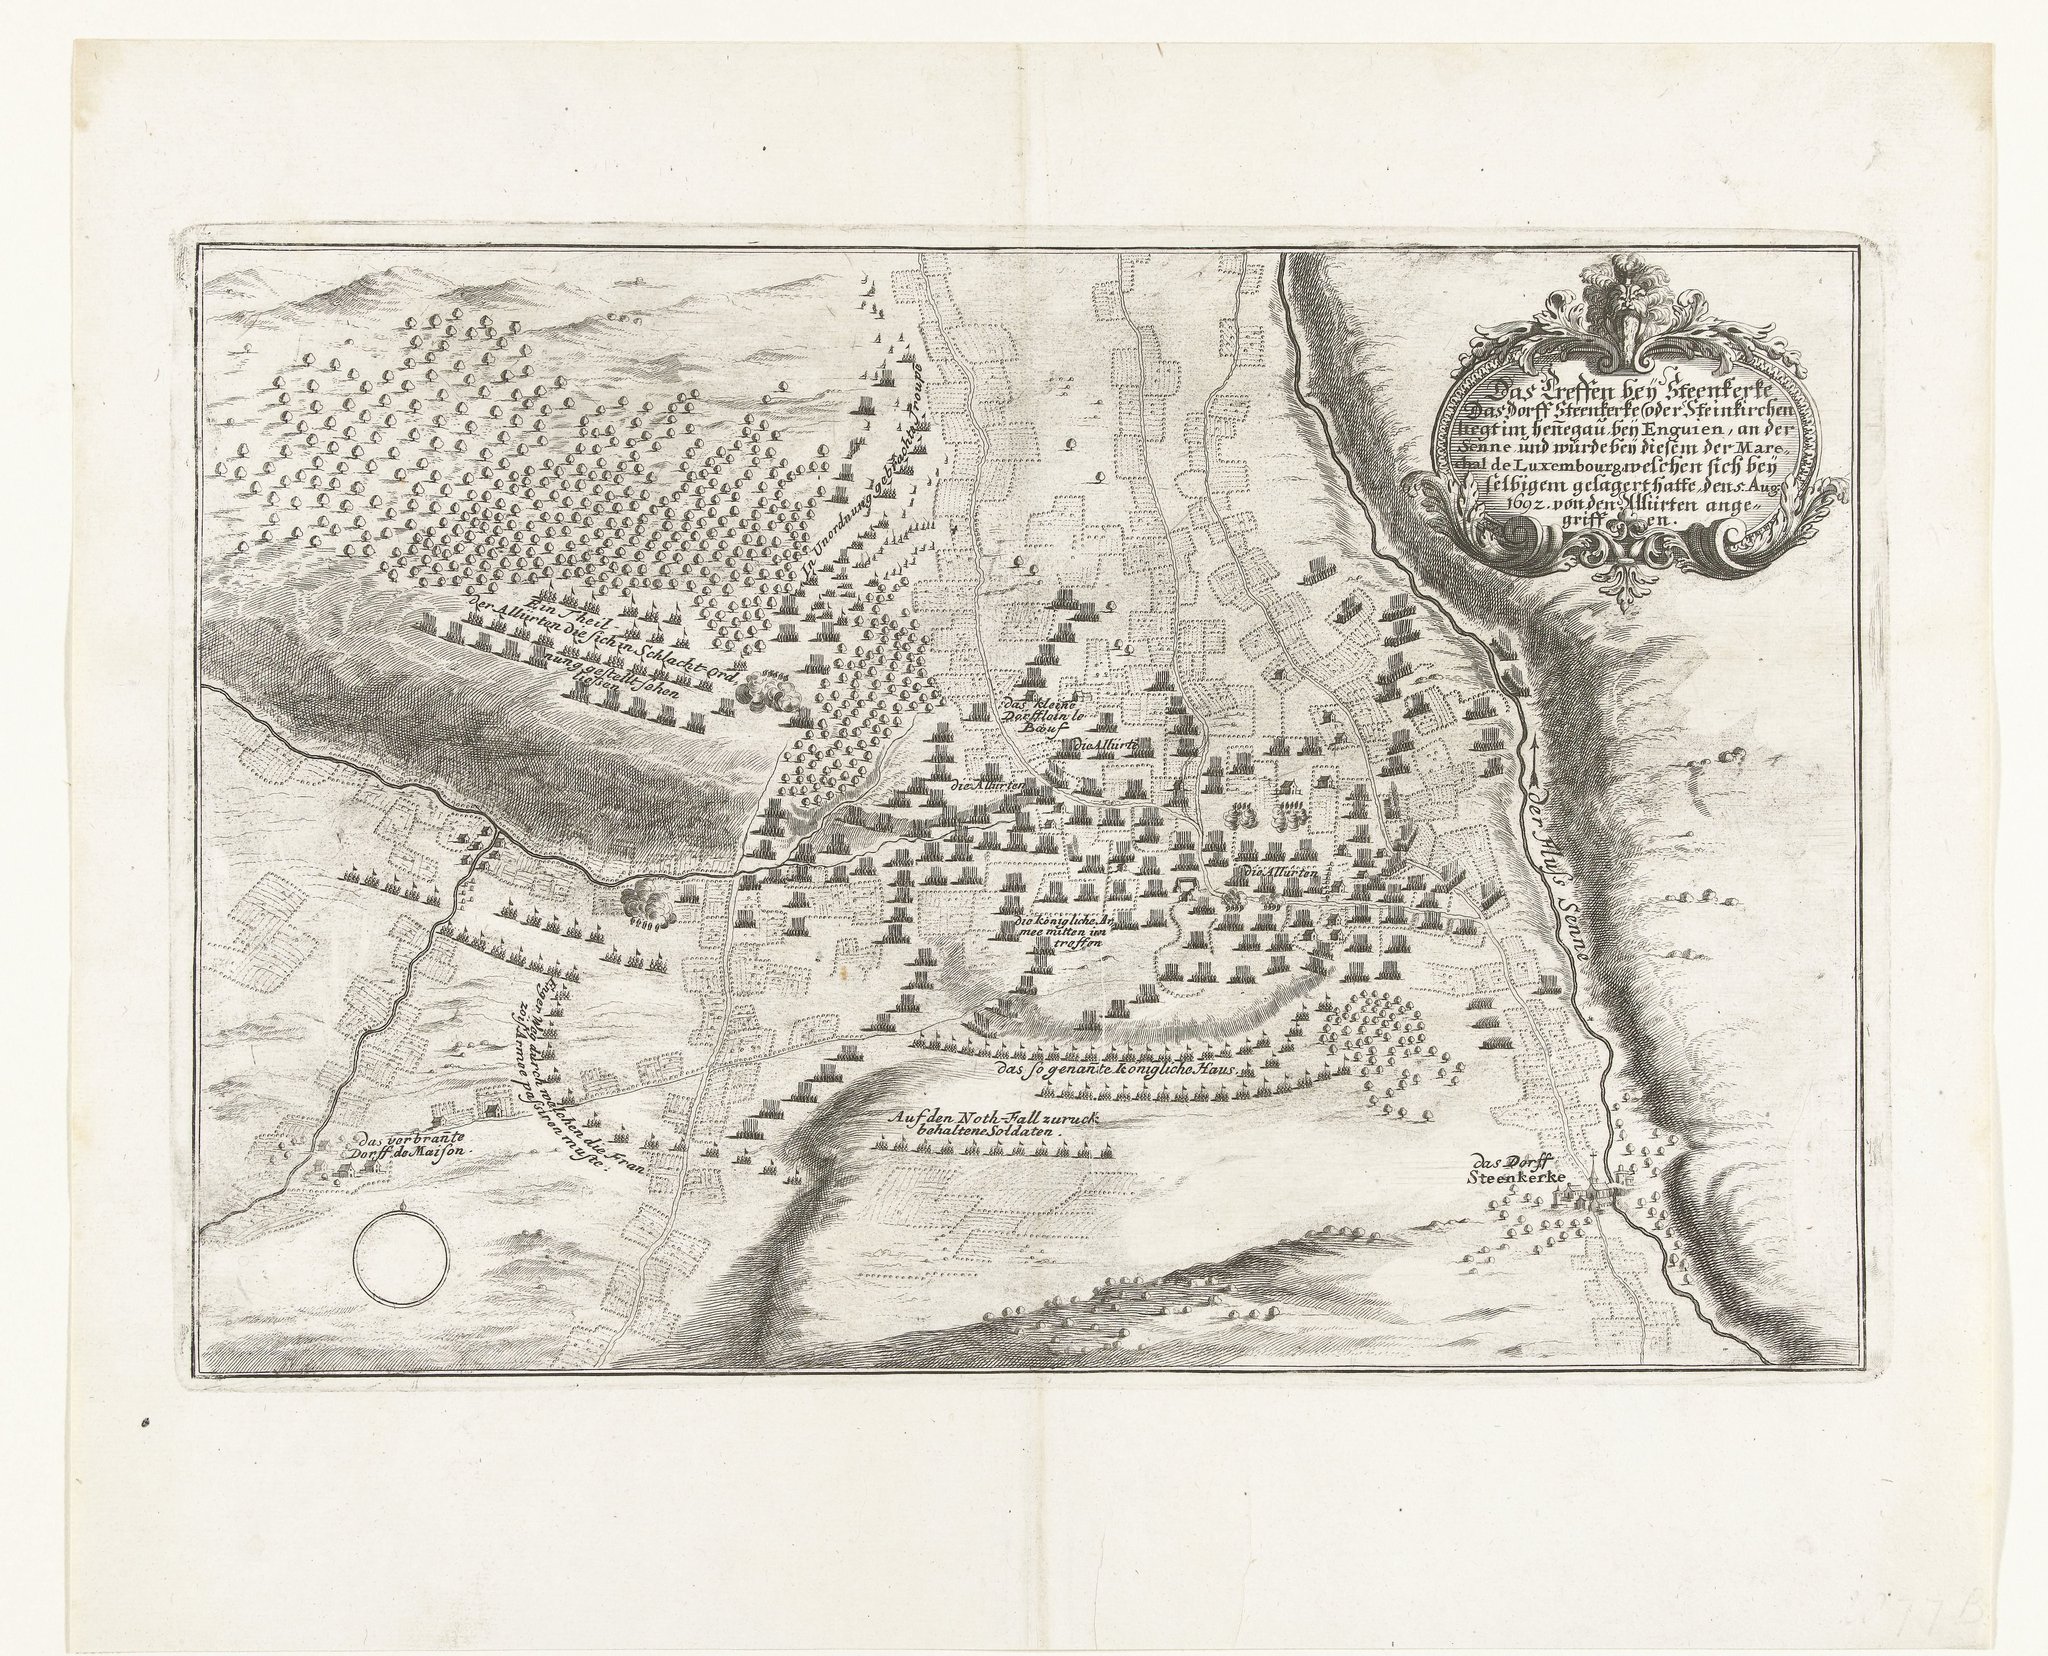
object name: print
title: Slag bij Steenkerke, 1692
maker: Anonymous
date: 1692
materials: paper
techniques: etching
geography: germany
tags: maps of separate countries or regions, battle (+ land forces)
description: Slag bij Steenkerke in Henegouwen waarbij het Franse leger onder de duc de Luxembourg de geallieerden onder koning Willem III versloeg, 3 augustus 1692.